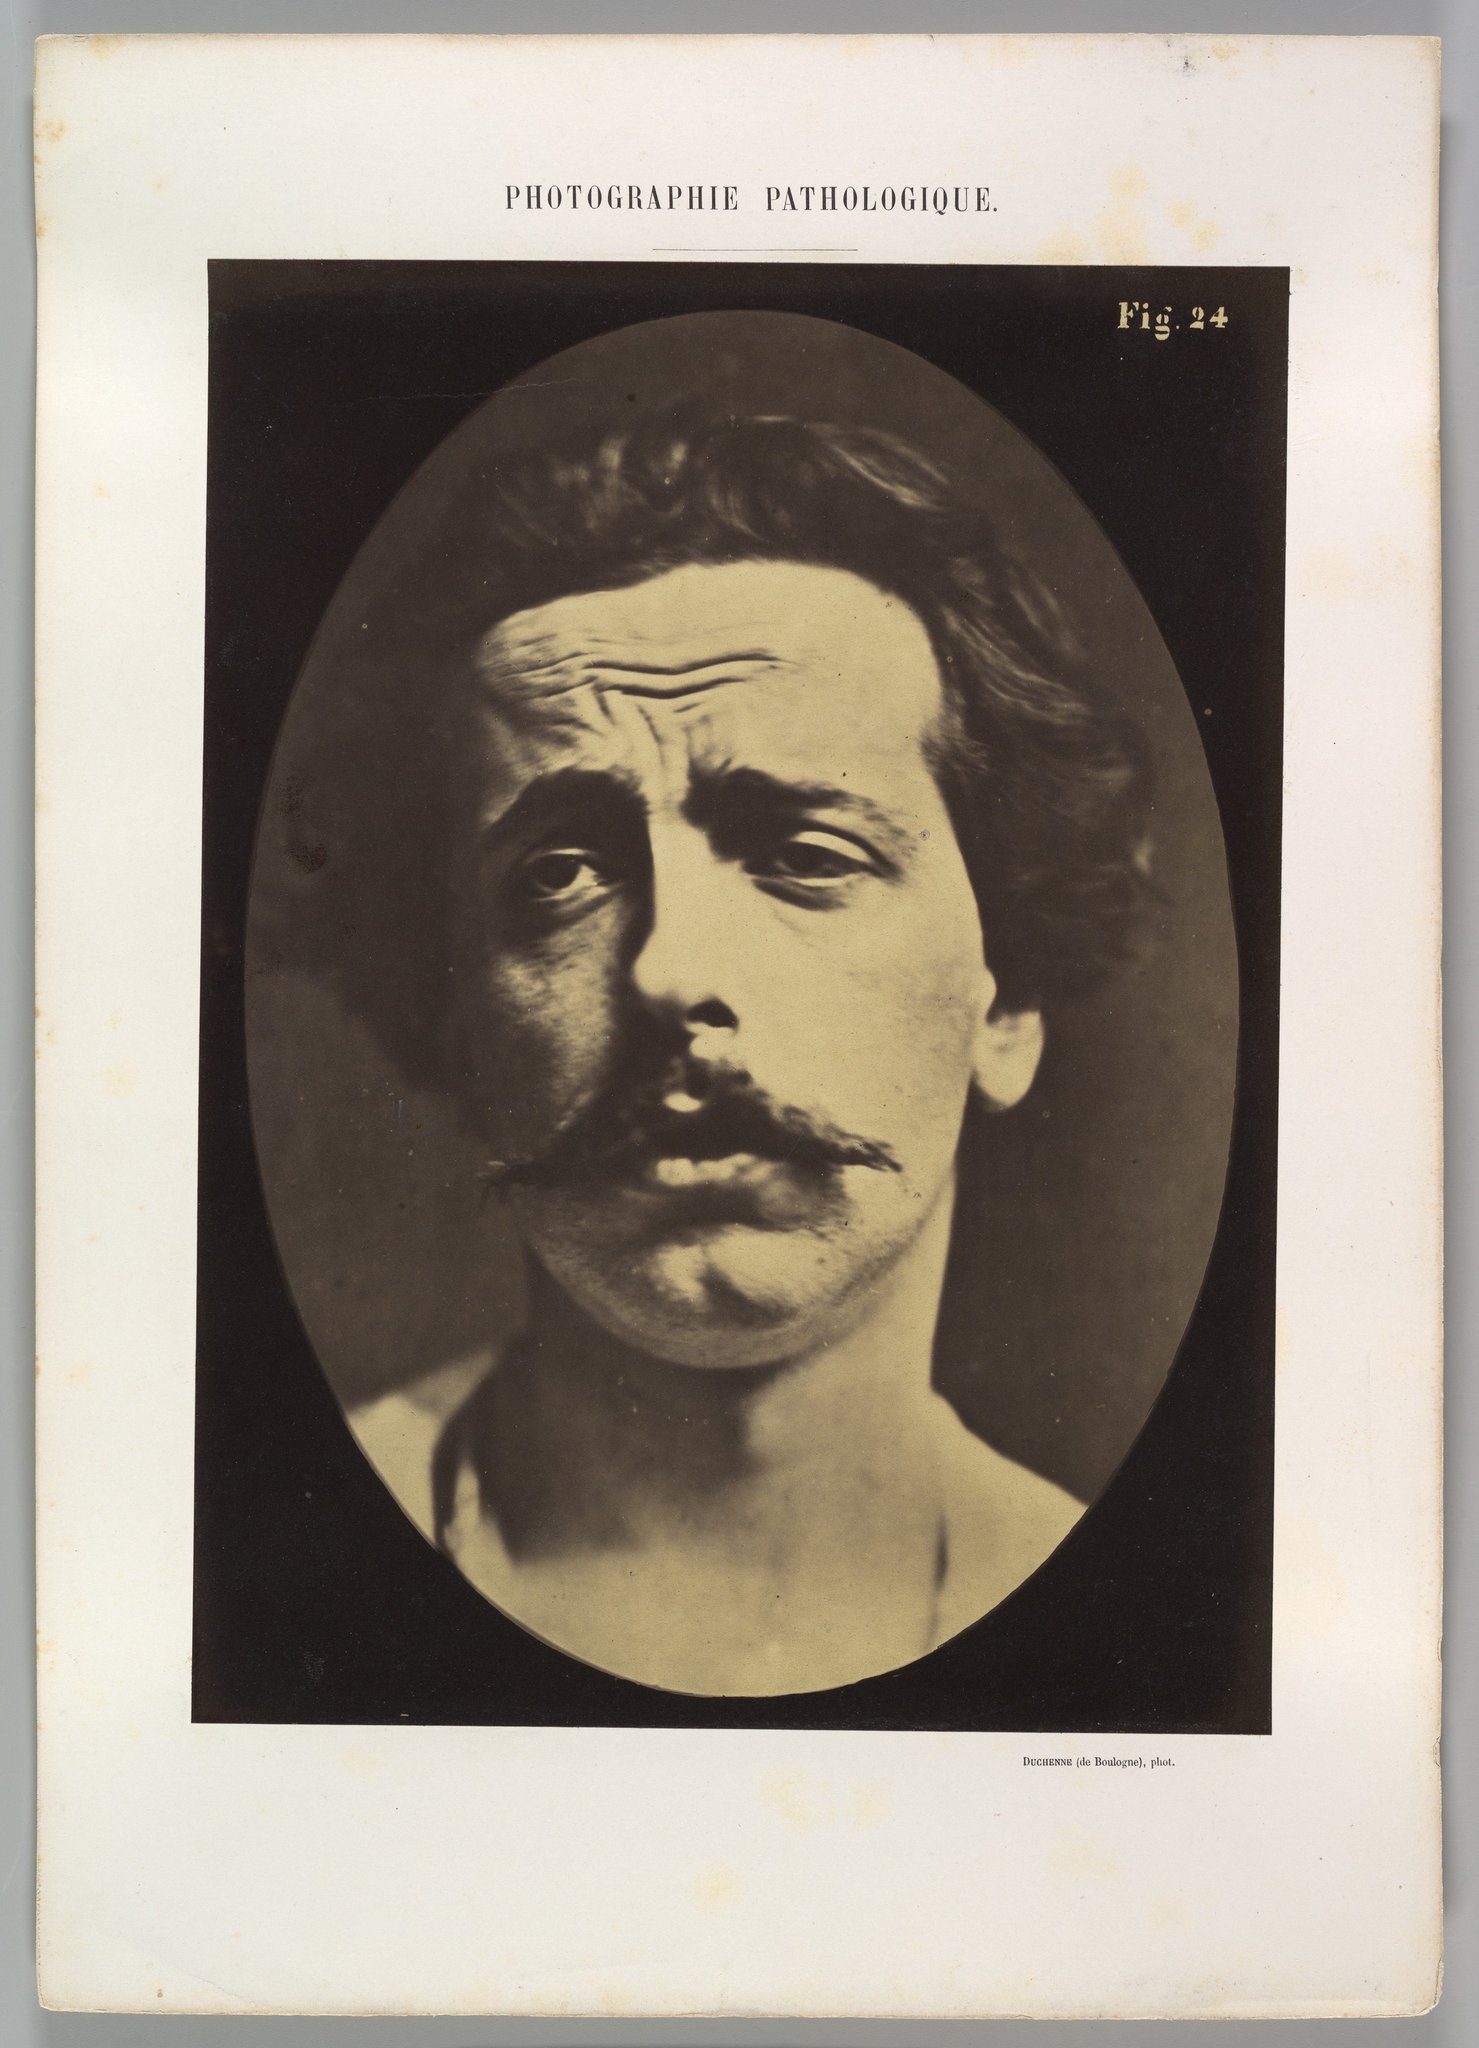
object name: photograph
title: Figure 24: Extreme pain to the point of exhaustion, the head of Christ and memory of love or ecstatic gaze.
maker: guillaume-benjamin-amand duchenne de boulogne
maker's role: artist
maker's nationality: french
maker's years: 1806-1875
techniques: albumen silver print, glass negative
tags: science,men,portraits